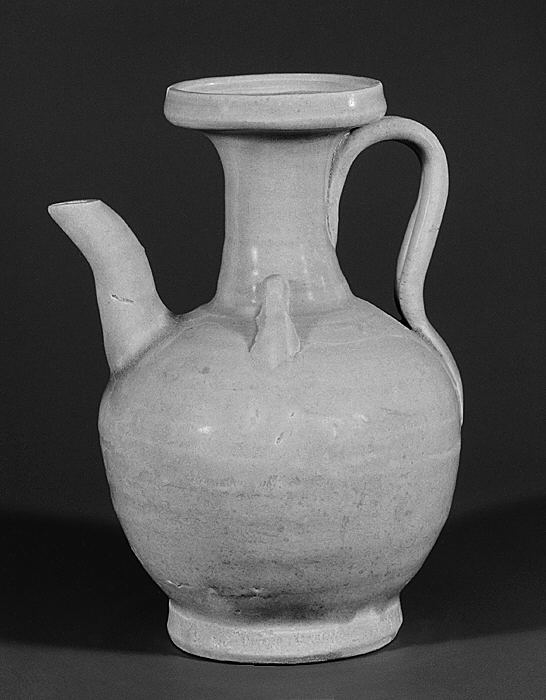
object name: ewer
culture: chinese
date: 901-1100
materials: ceramic glaze, glaze, stoneware